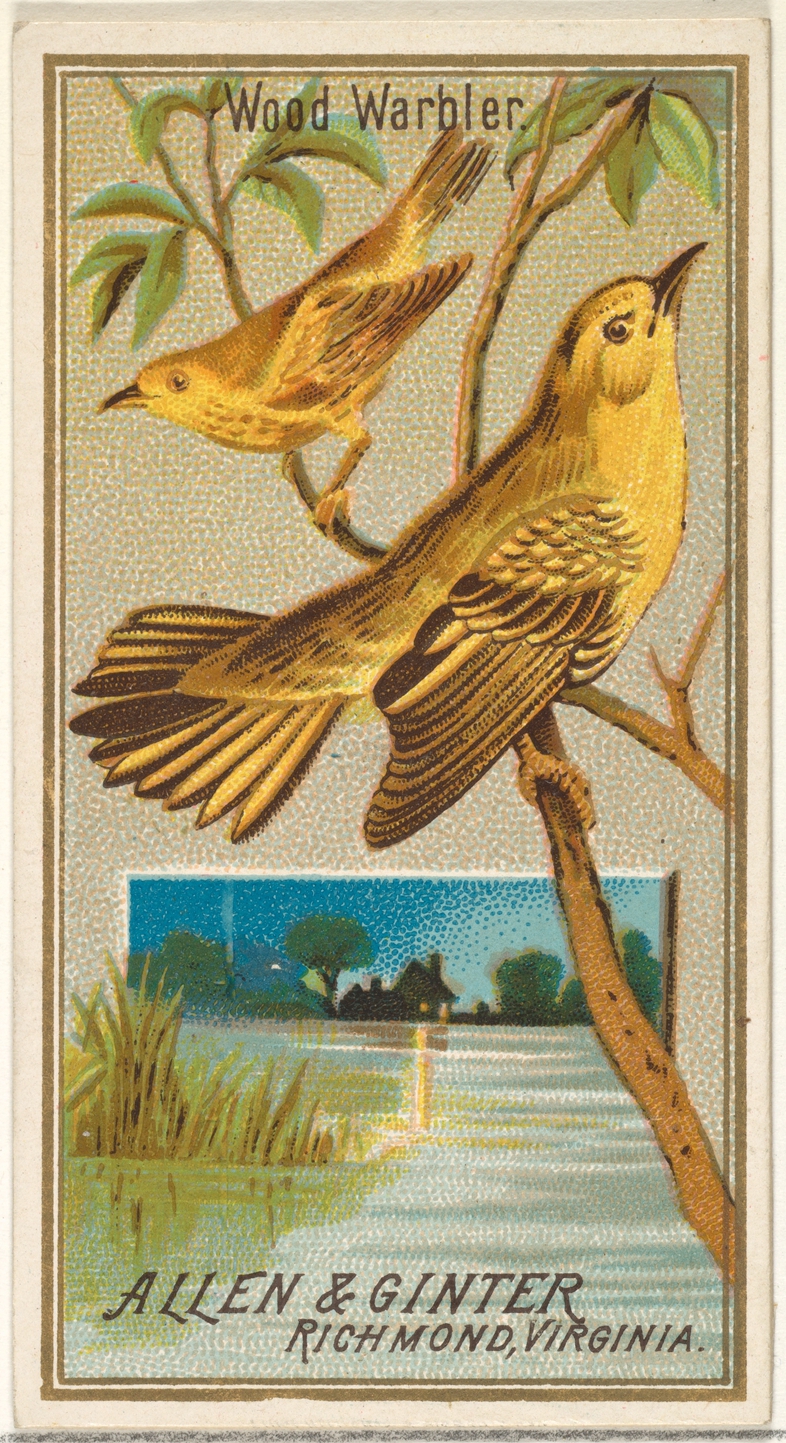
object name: print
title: Wood Warbler, from the Birds of America series (N4) for Allen & Ginter Cigarettes Brands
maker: allen & ginter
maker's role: publisher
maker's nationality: american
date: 1888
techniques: color lithograph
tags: birds